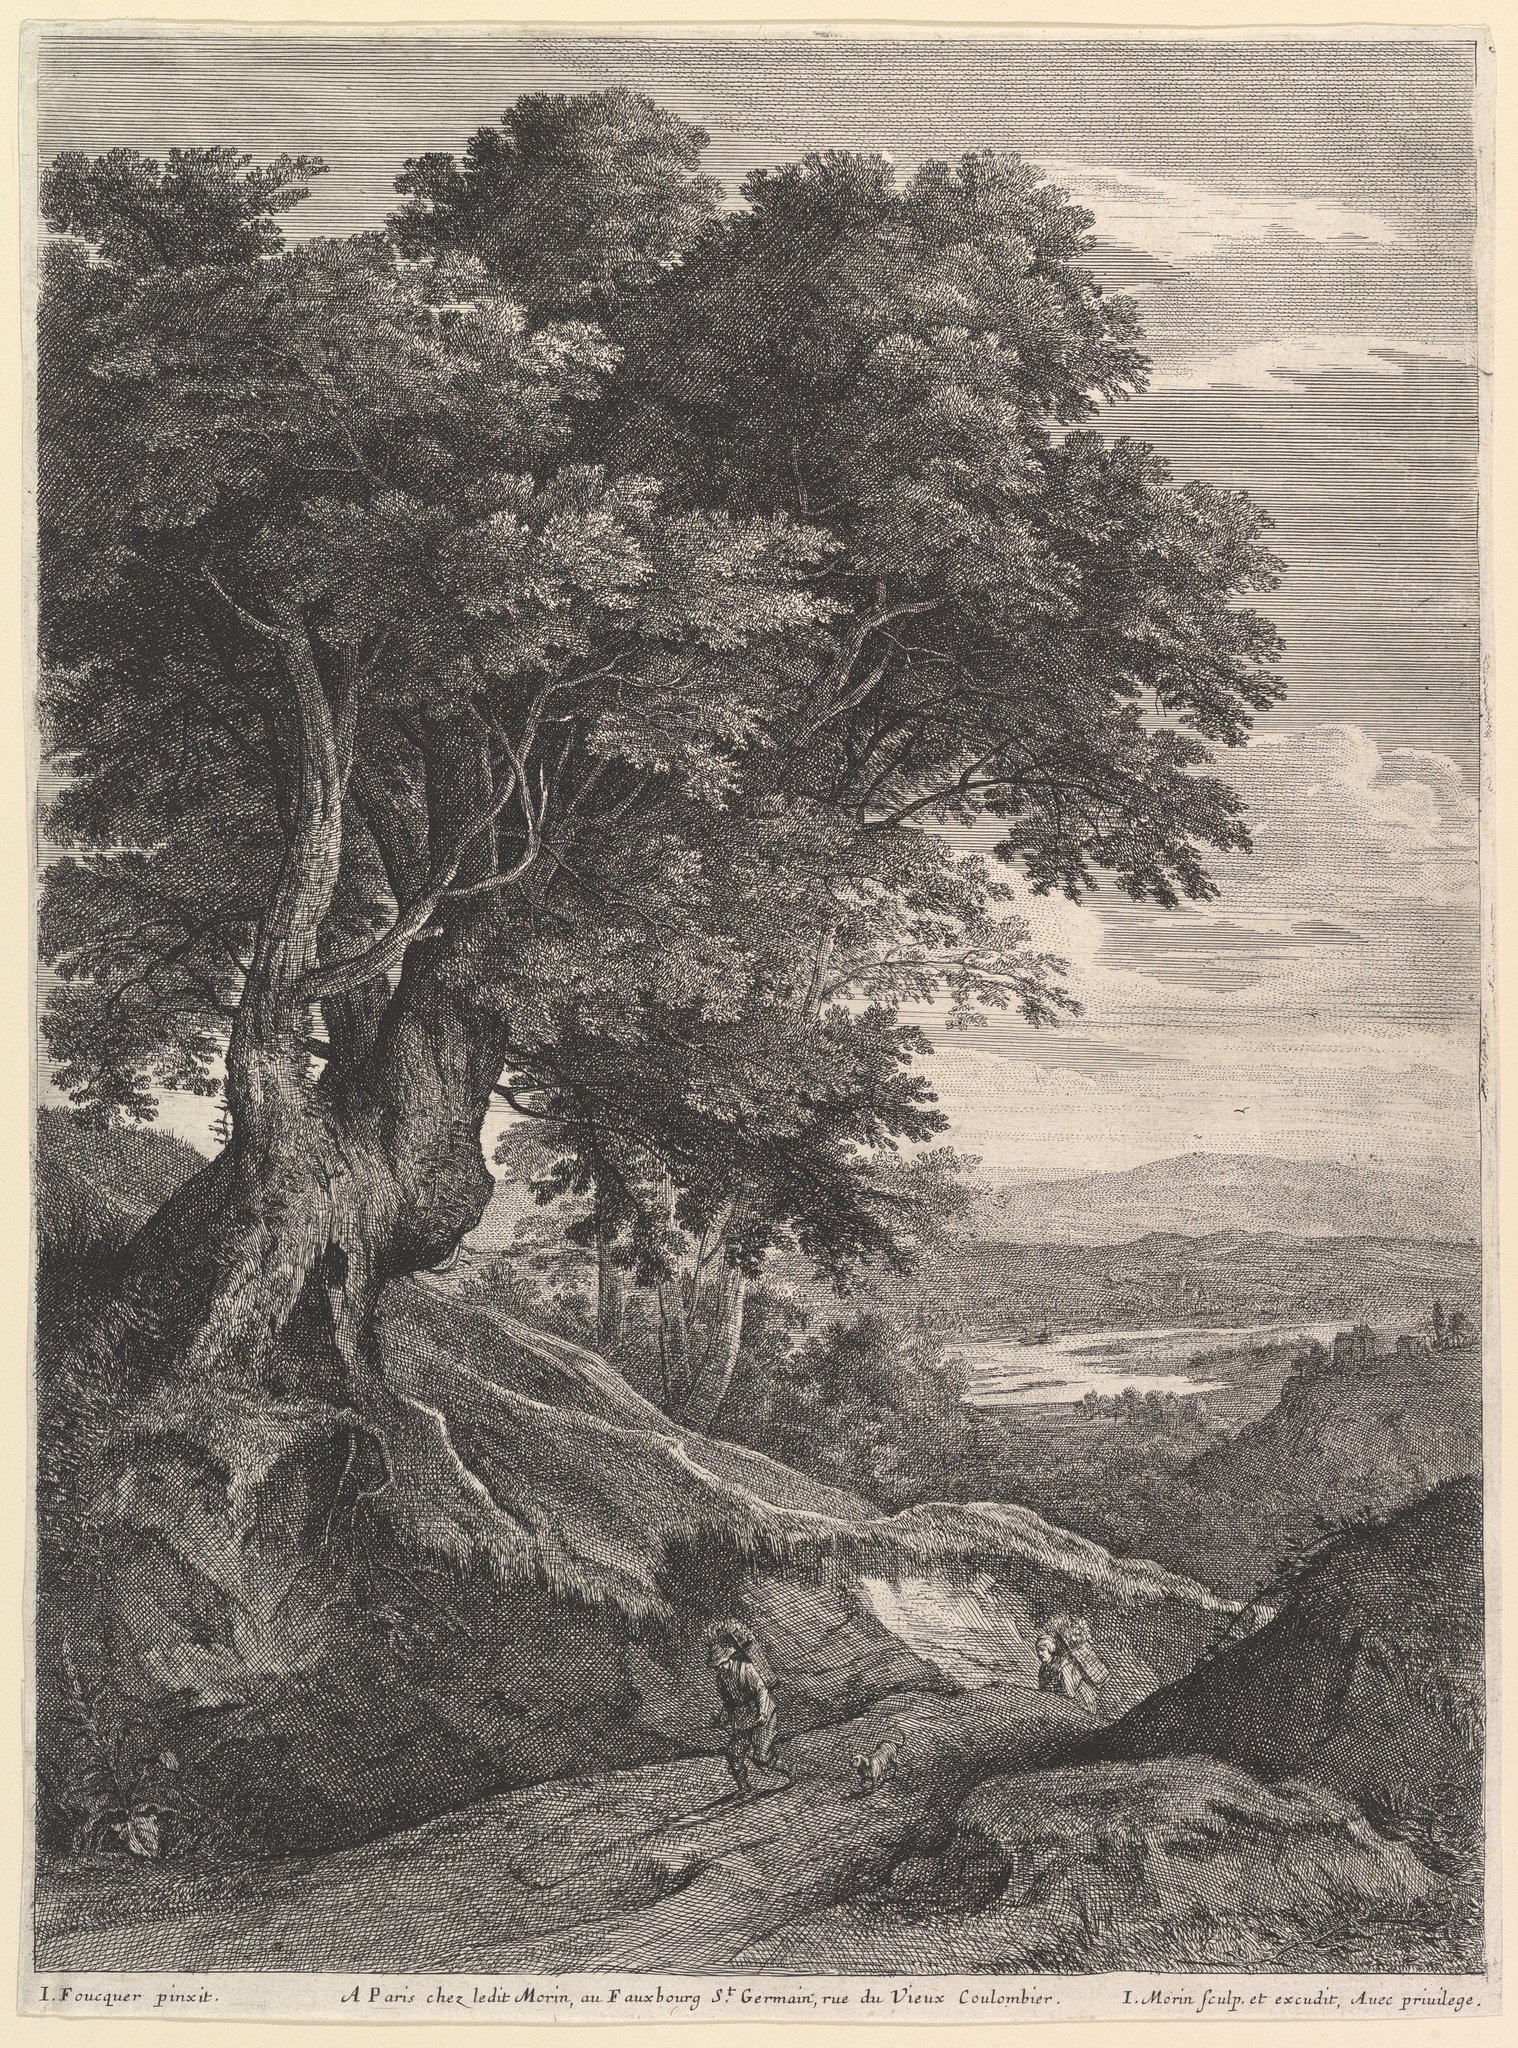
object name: print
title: Paysan et Paysanne en Marche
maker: jean morin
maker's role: artist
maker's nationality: french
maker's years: 1605-1650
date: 1605-1650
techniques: etching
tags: human figures,trees